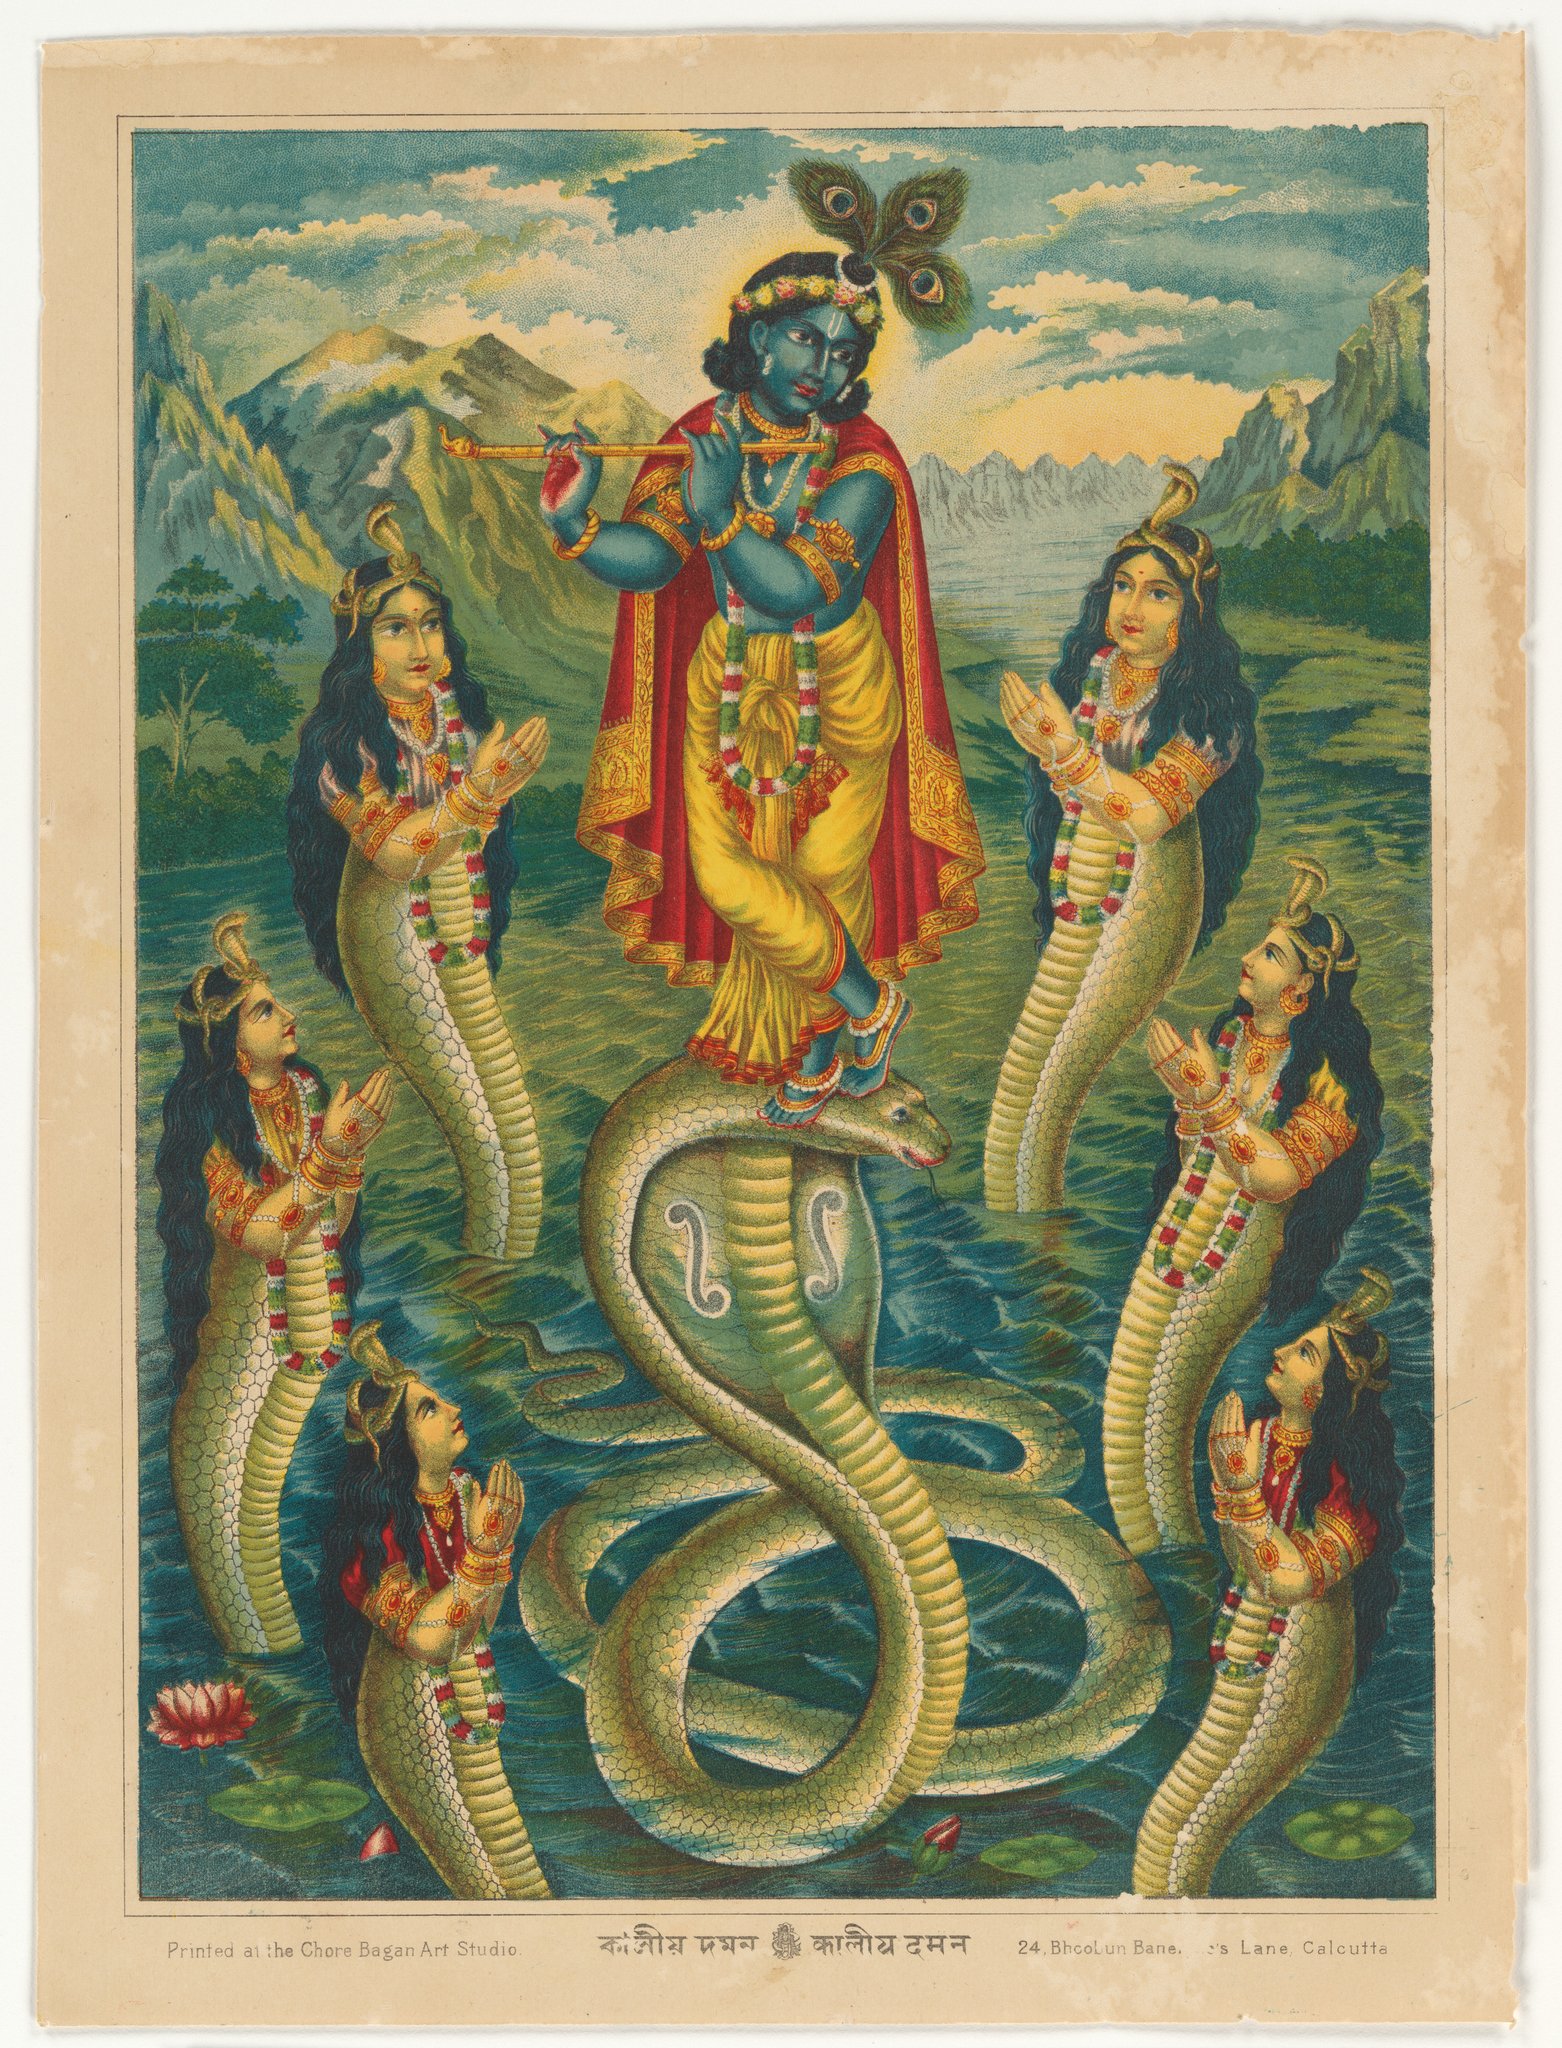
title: Krishna subduing Kaliya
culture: west bengali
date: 1885-1895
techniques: lithograph